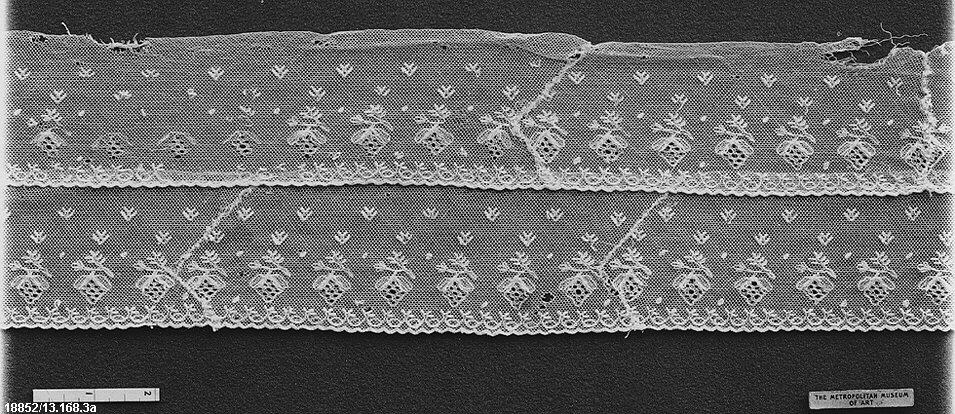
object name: fragment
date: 1801-1833